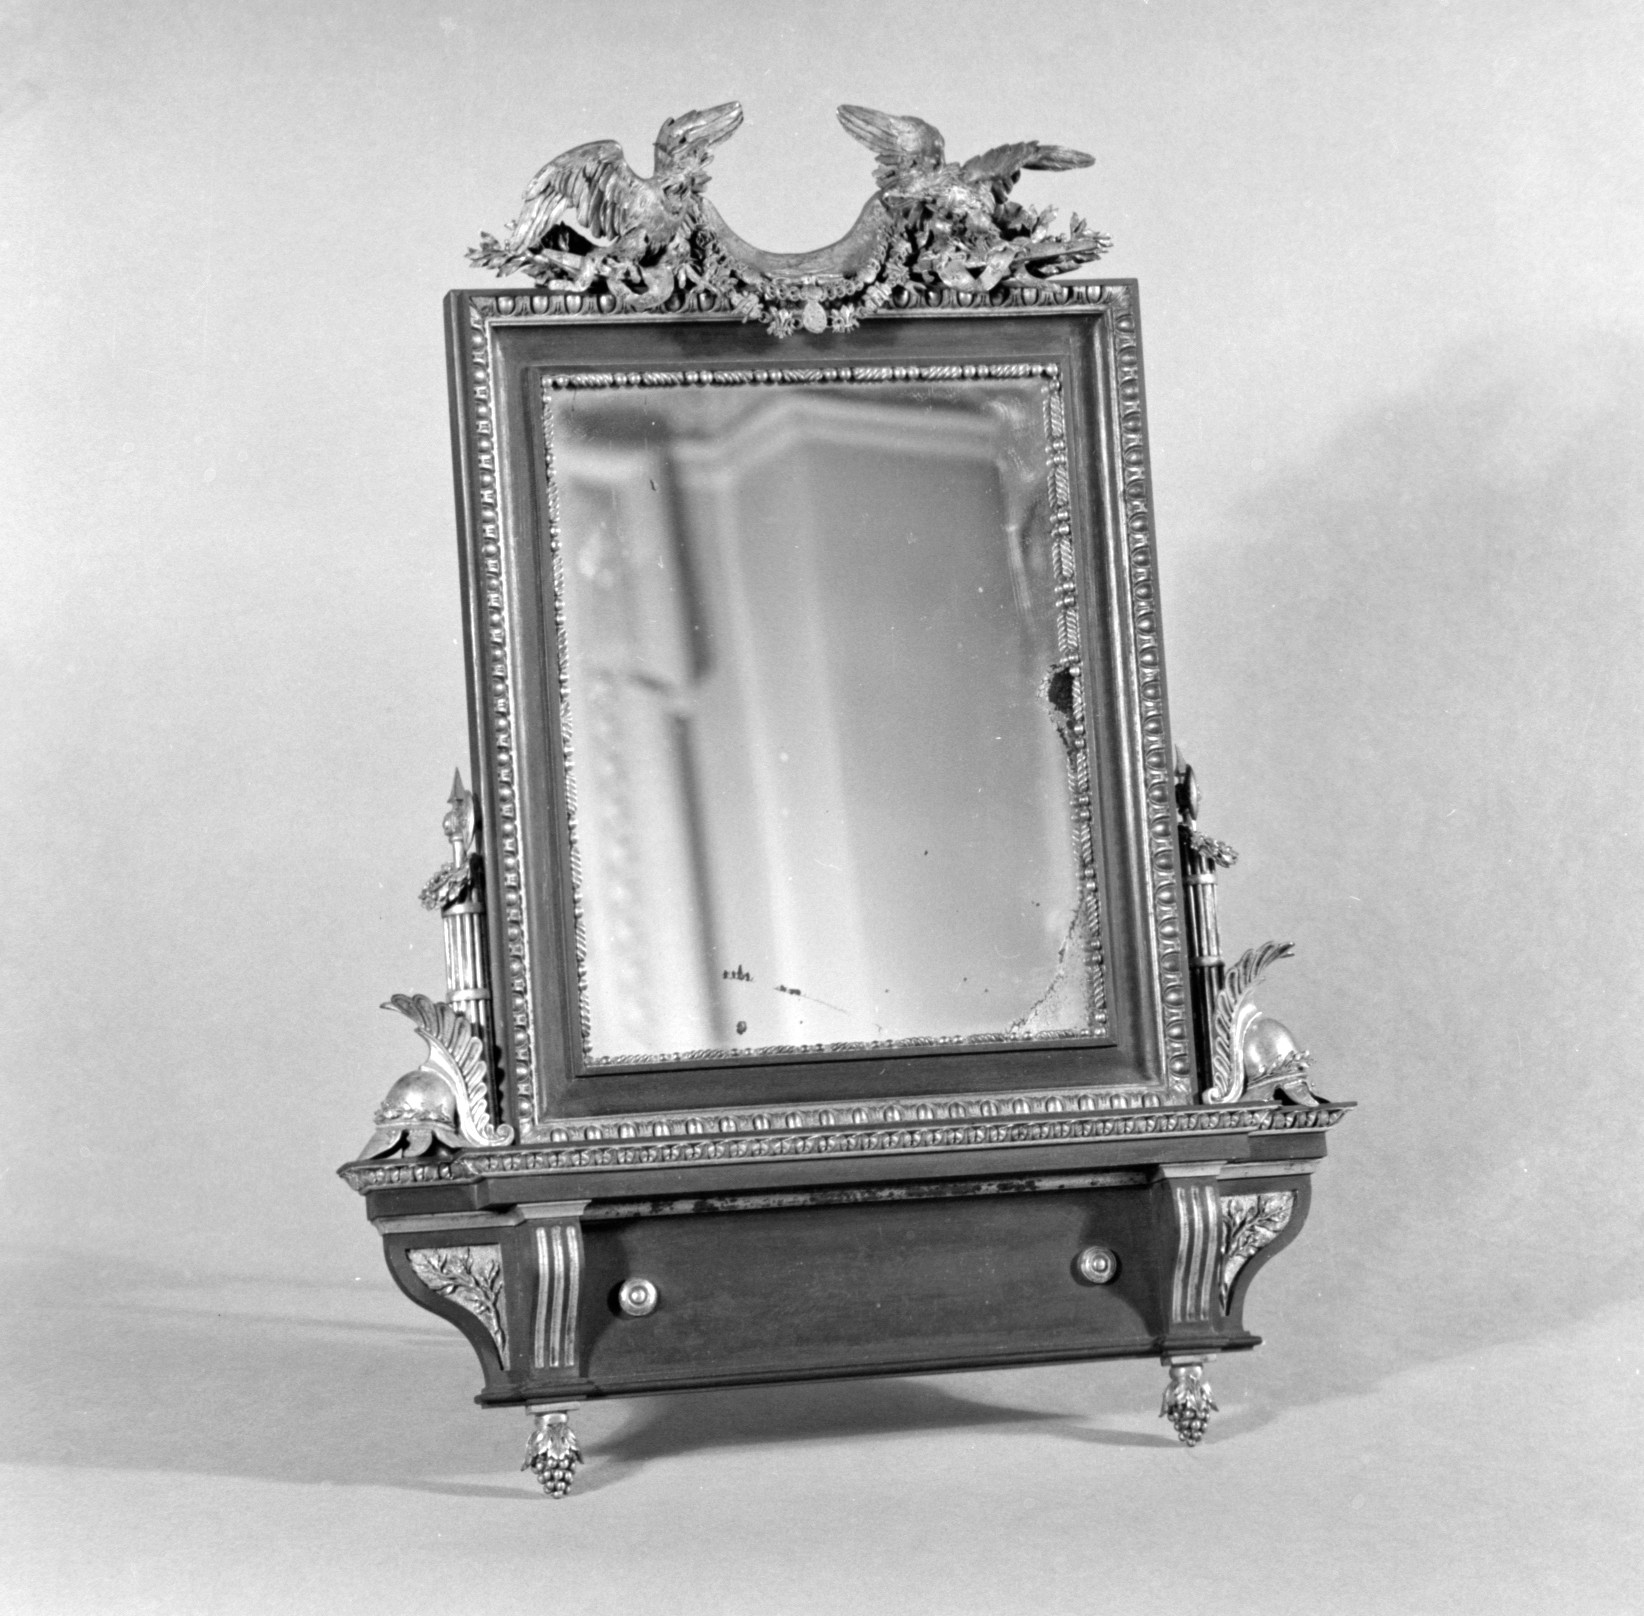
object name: toilet mirror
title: Rectangular toilet mirror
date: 1870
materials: bronze, gilt bronze